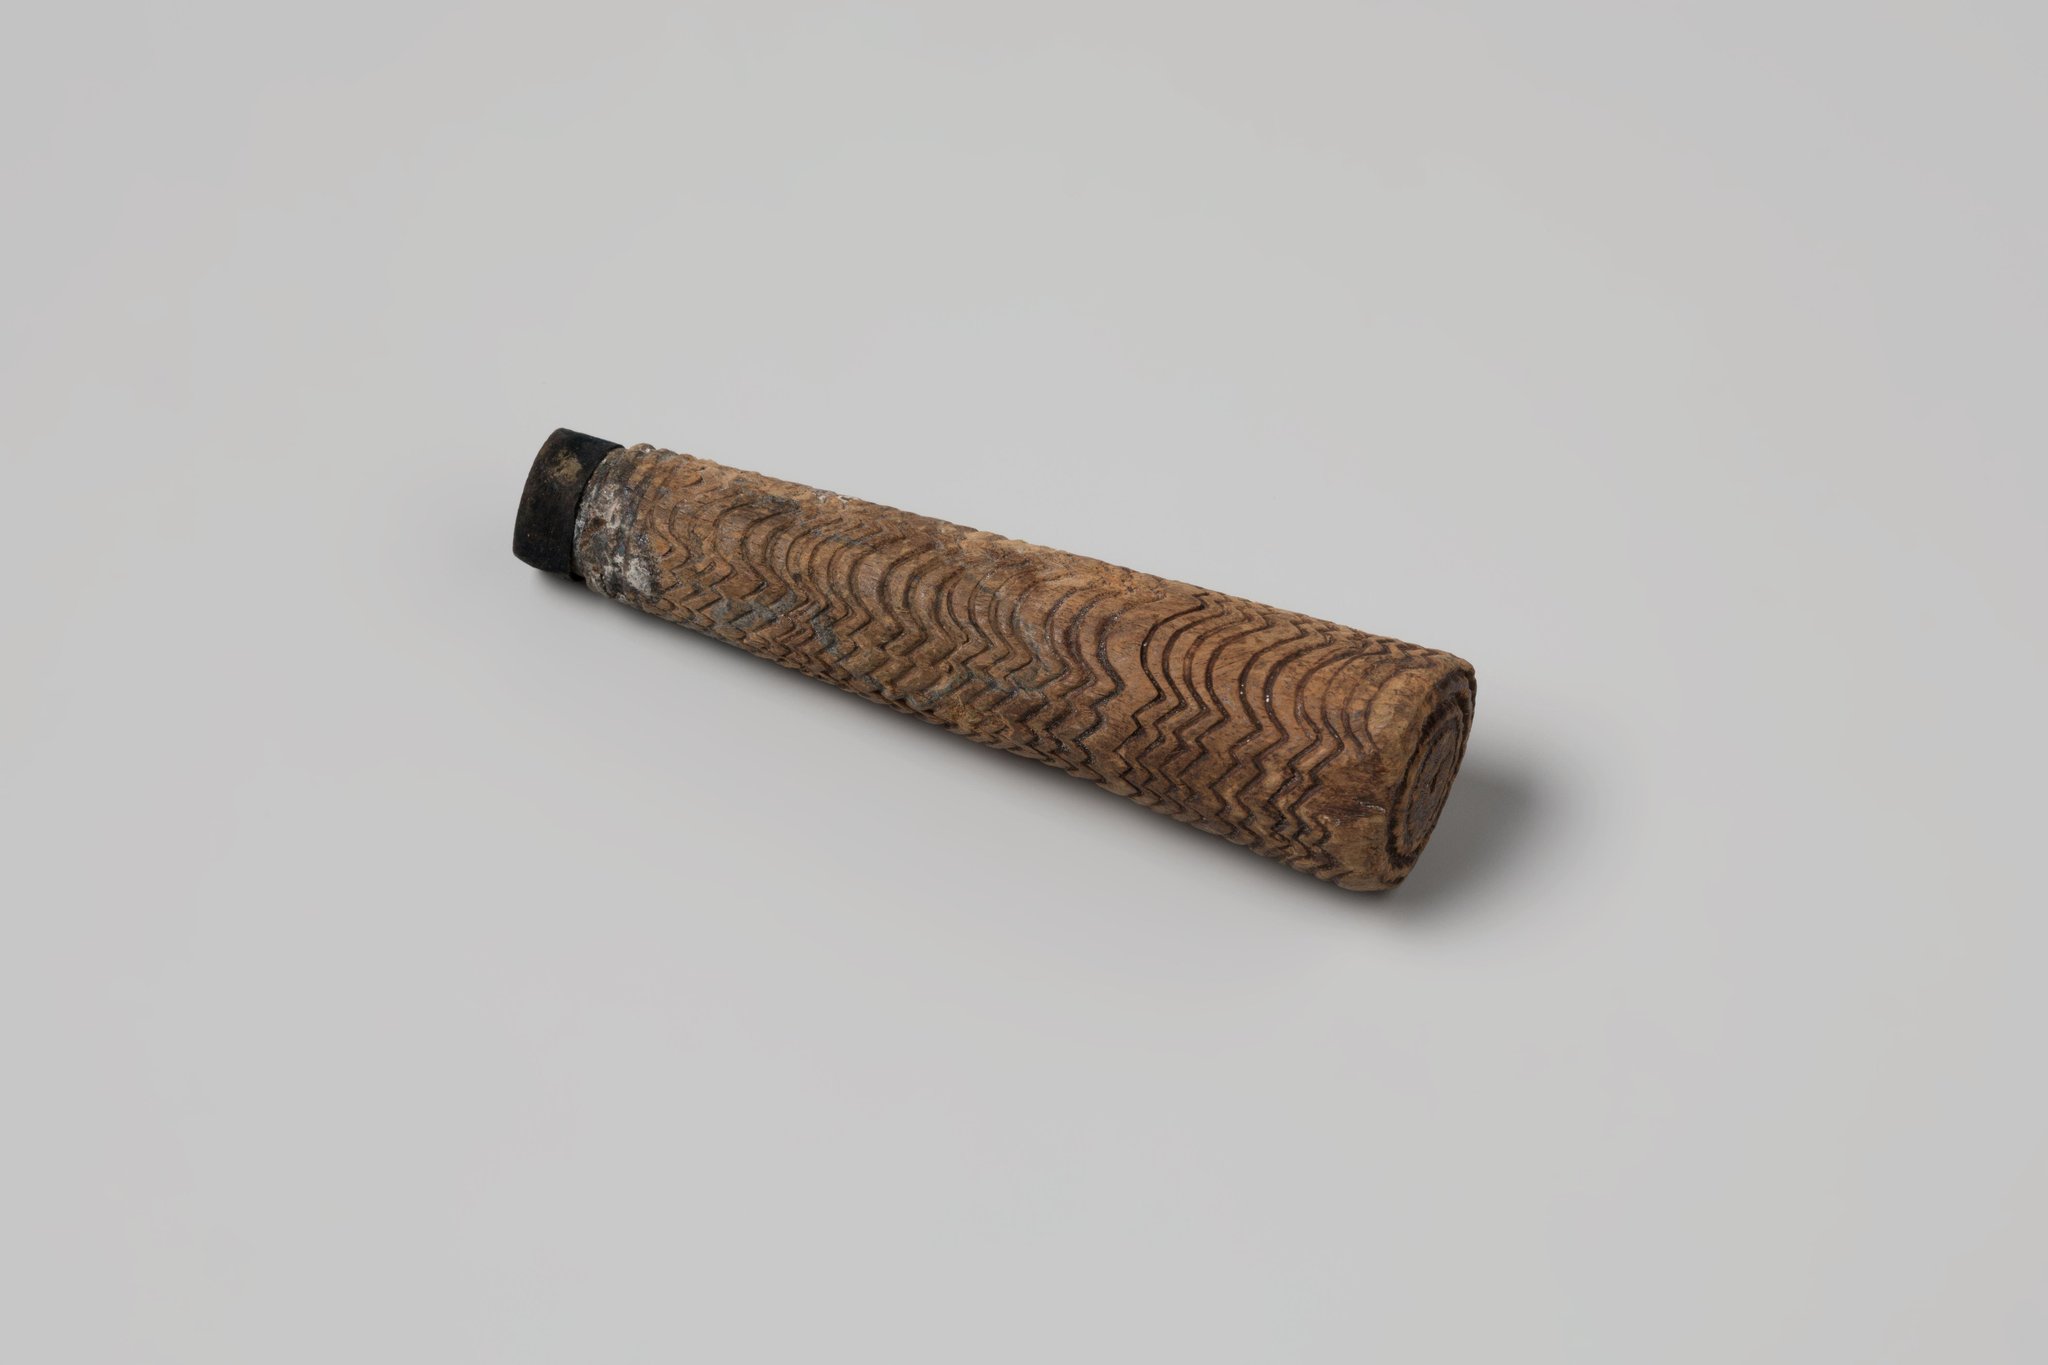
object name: knife handle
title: Messenheft uit het wrak van de Oost-Indiëvaarder Hollandia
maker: Anonymous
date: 1700-1743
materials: metal, wood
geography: netherlands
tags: verenigde oostindische compagnie, hollandia (schip), annet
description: Knife, handle, cylindrical: tapering; flat upper end, turned decoration of dense wavy lines, concentric circles at lower end, ferrule id. NG 1980-27H426.